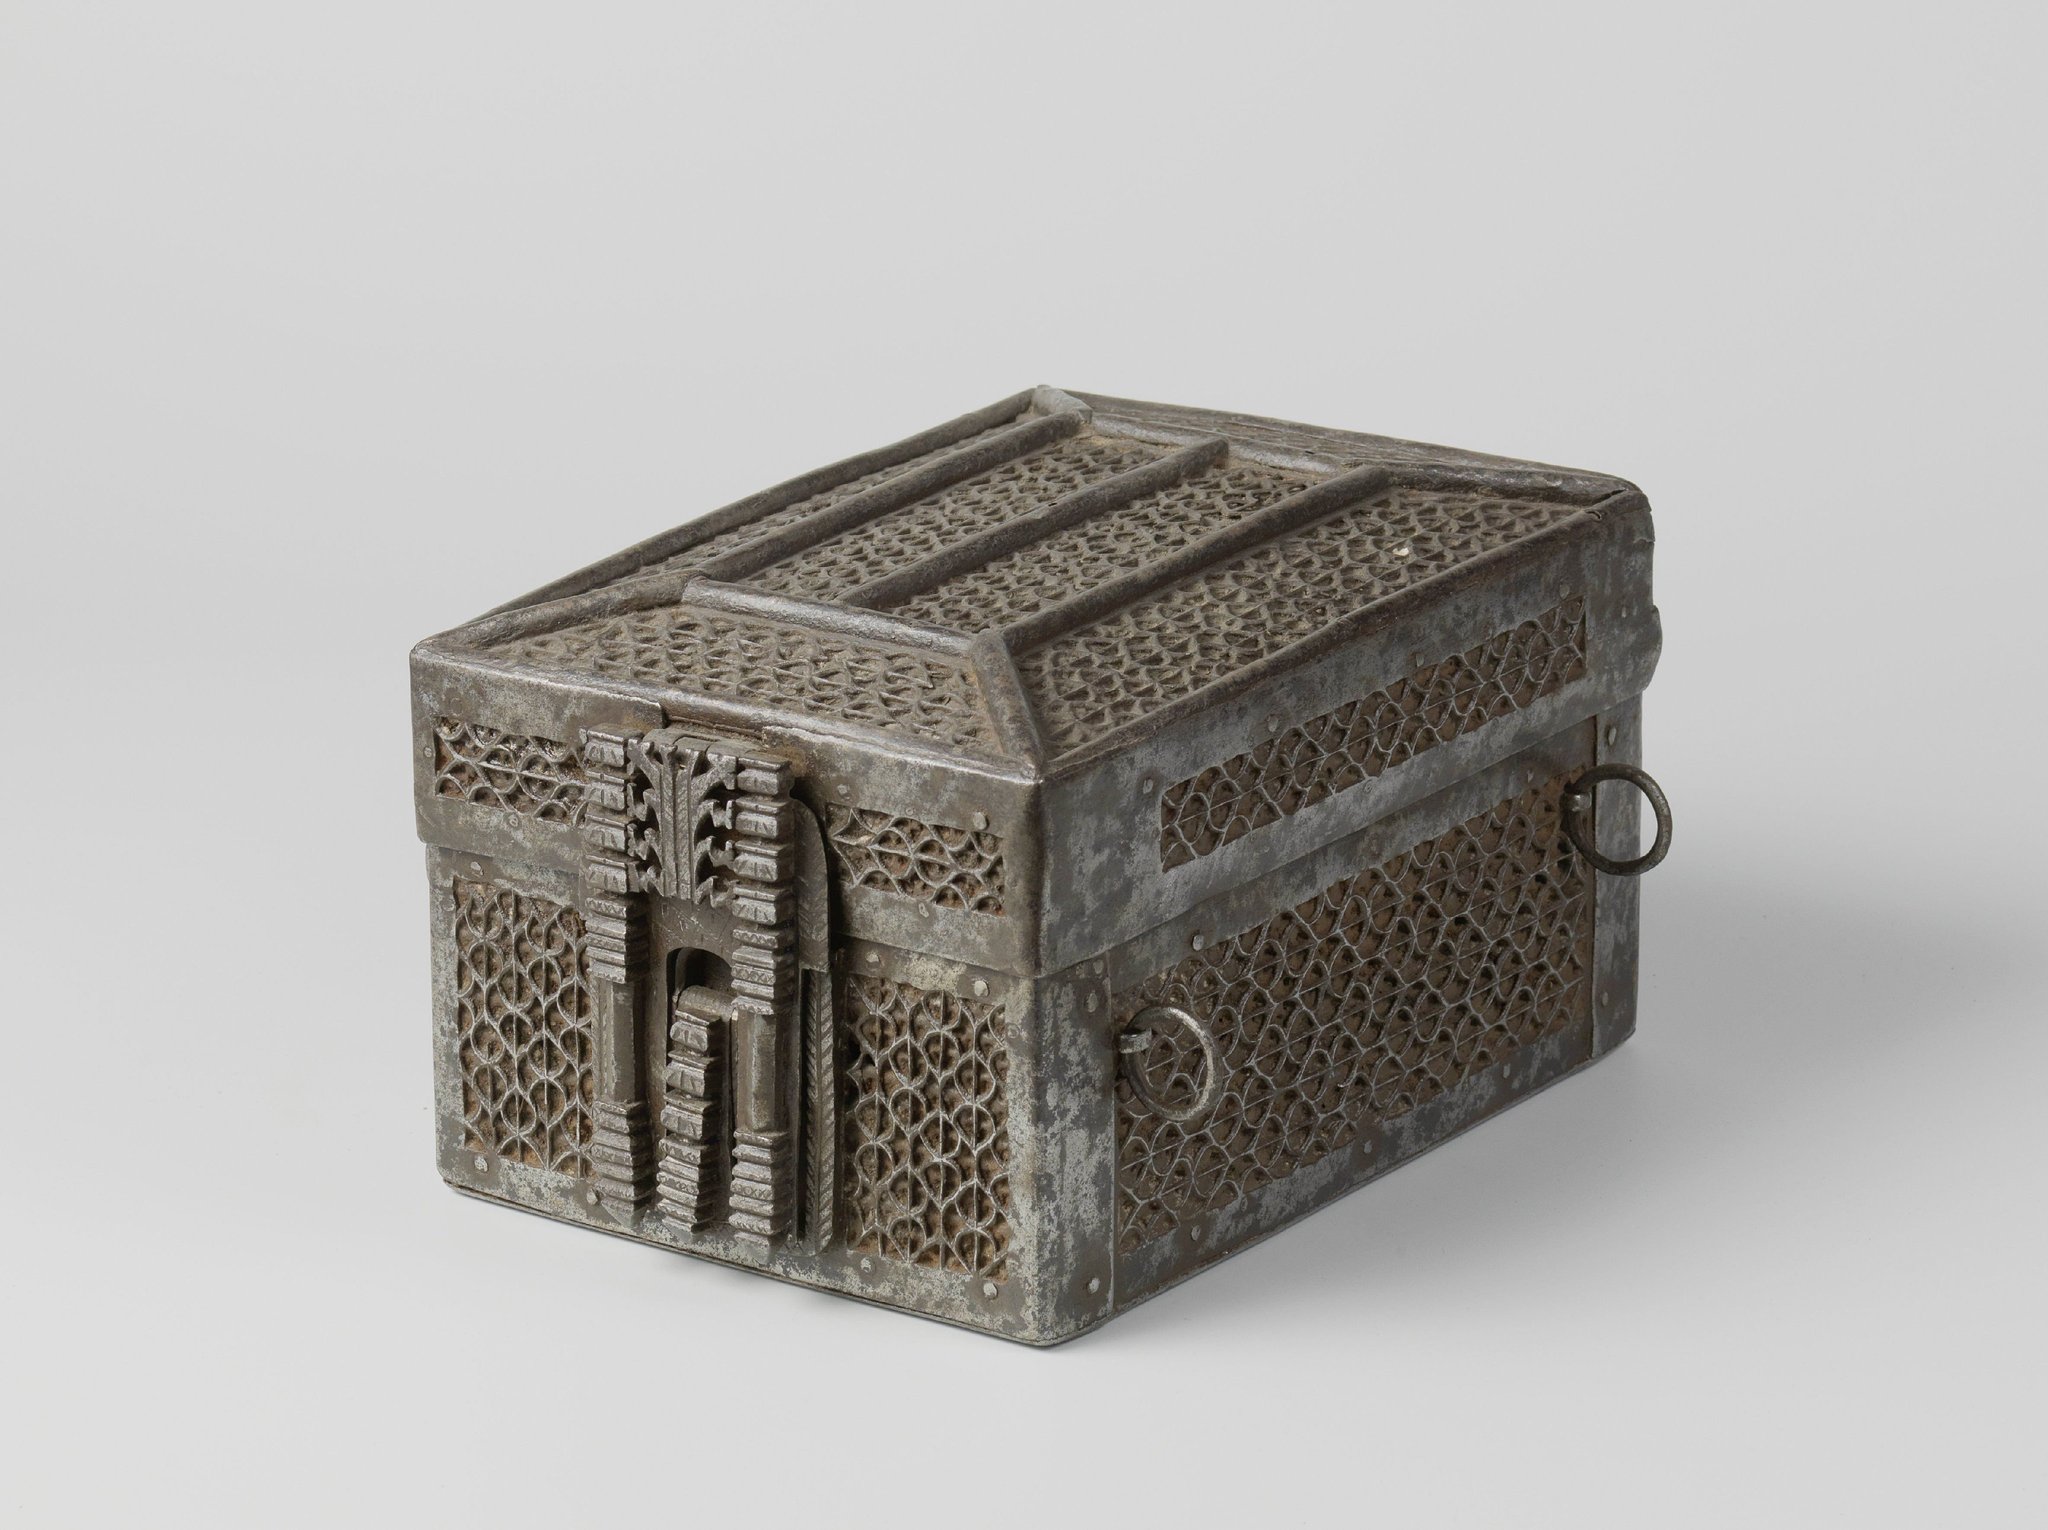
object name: chest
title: Casket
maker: Anonymous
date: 1500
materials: iron, wood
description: Een rechthoekig draag kist waarvan de ijzeren opengewerkte wanden op een houten kern gemonteerd zijn, heeft een deksel dat in het midden eenigzins verhoogd is. De lange zijwanden hebben ieder twee ringen. Het slot is verbogen achter pilasters. Gemerkt.